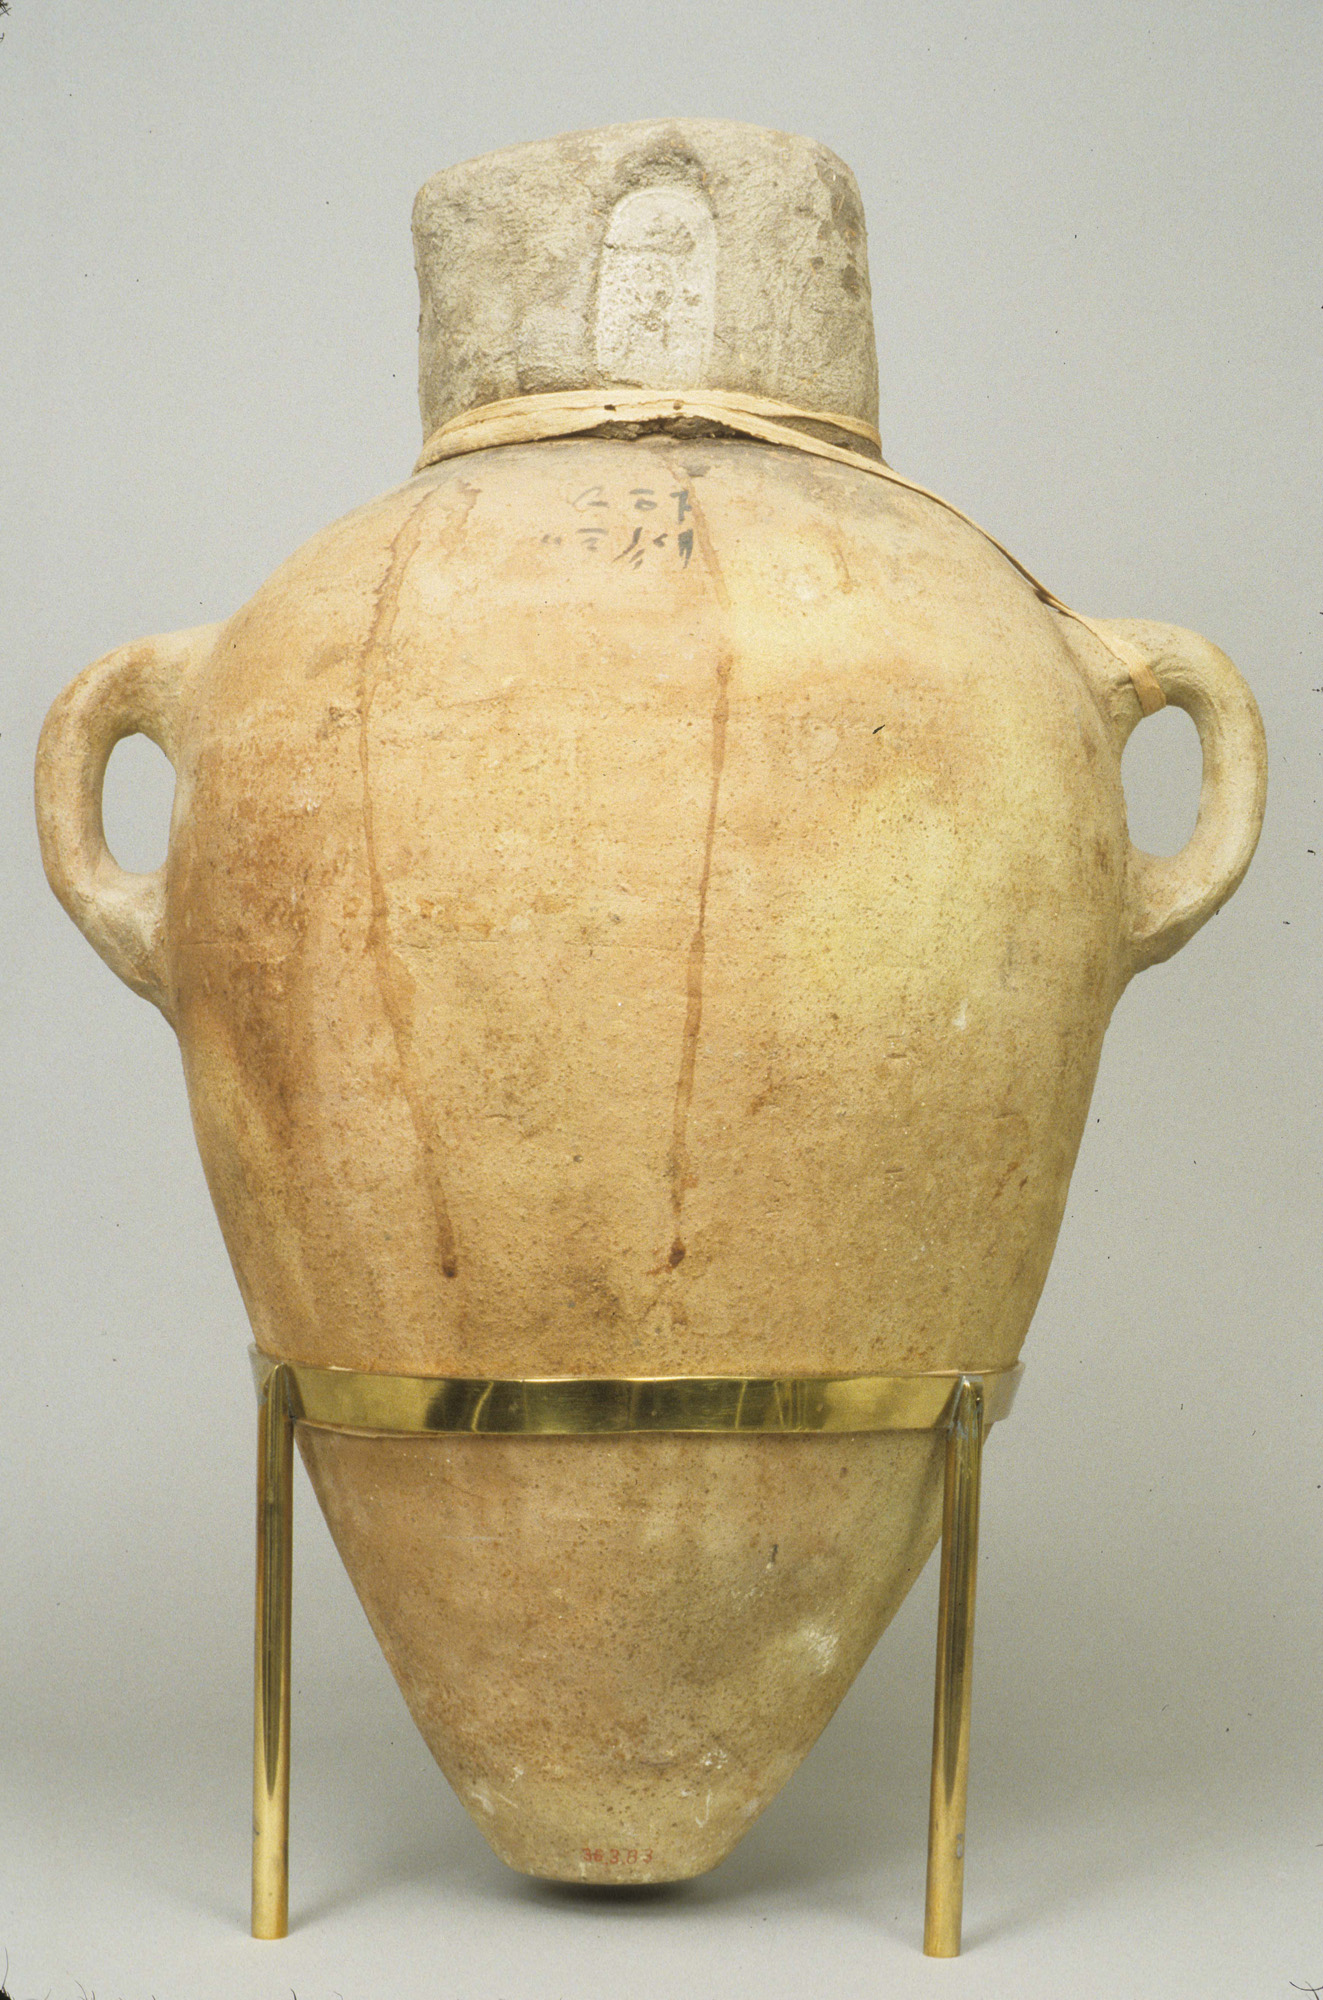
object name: pottery, amphora, sealed, hatnefer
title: Sealed Amphora Containing Oil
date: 1492-1473 BCE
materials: clay, linen, mud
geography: egypt